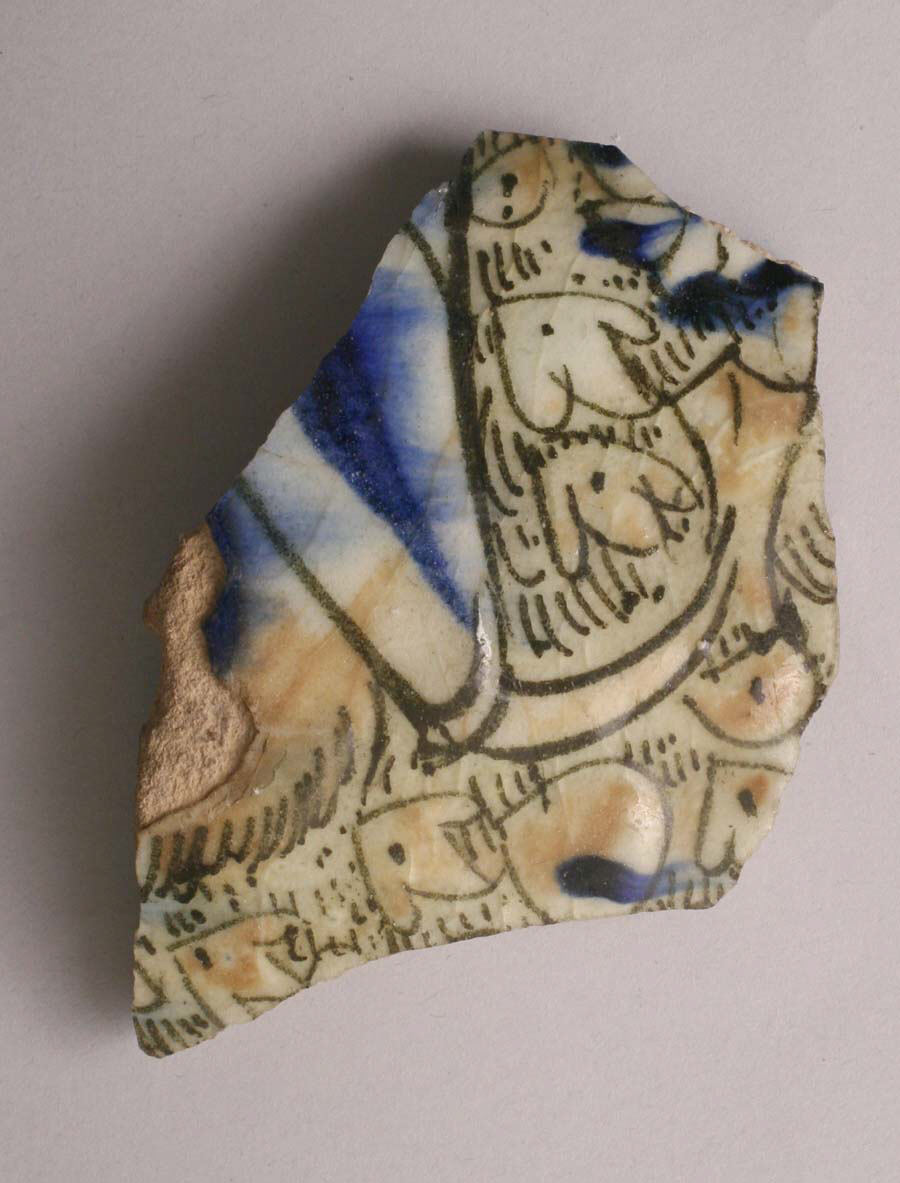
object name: ceramic fragment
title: Fragment of Dish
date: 1301-1400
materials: glaze, stonepaste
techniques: painting, polychrome, underglaze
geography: syria